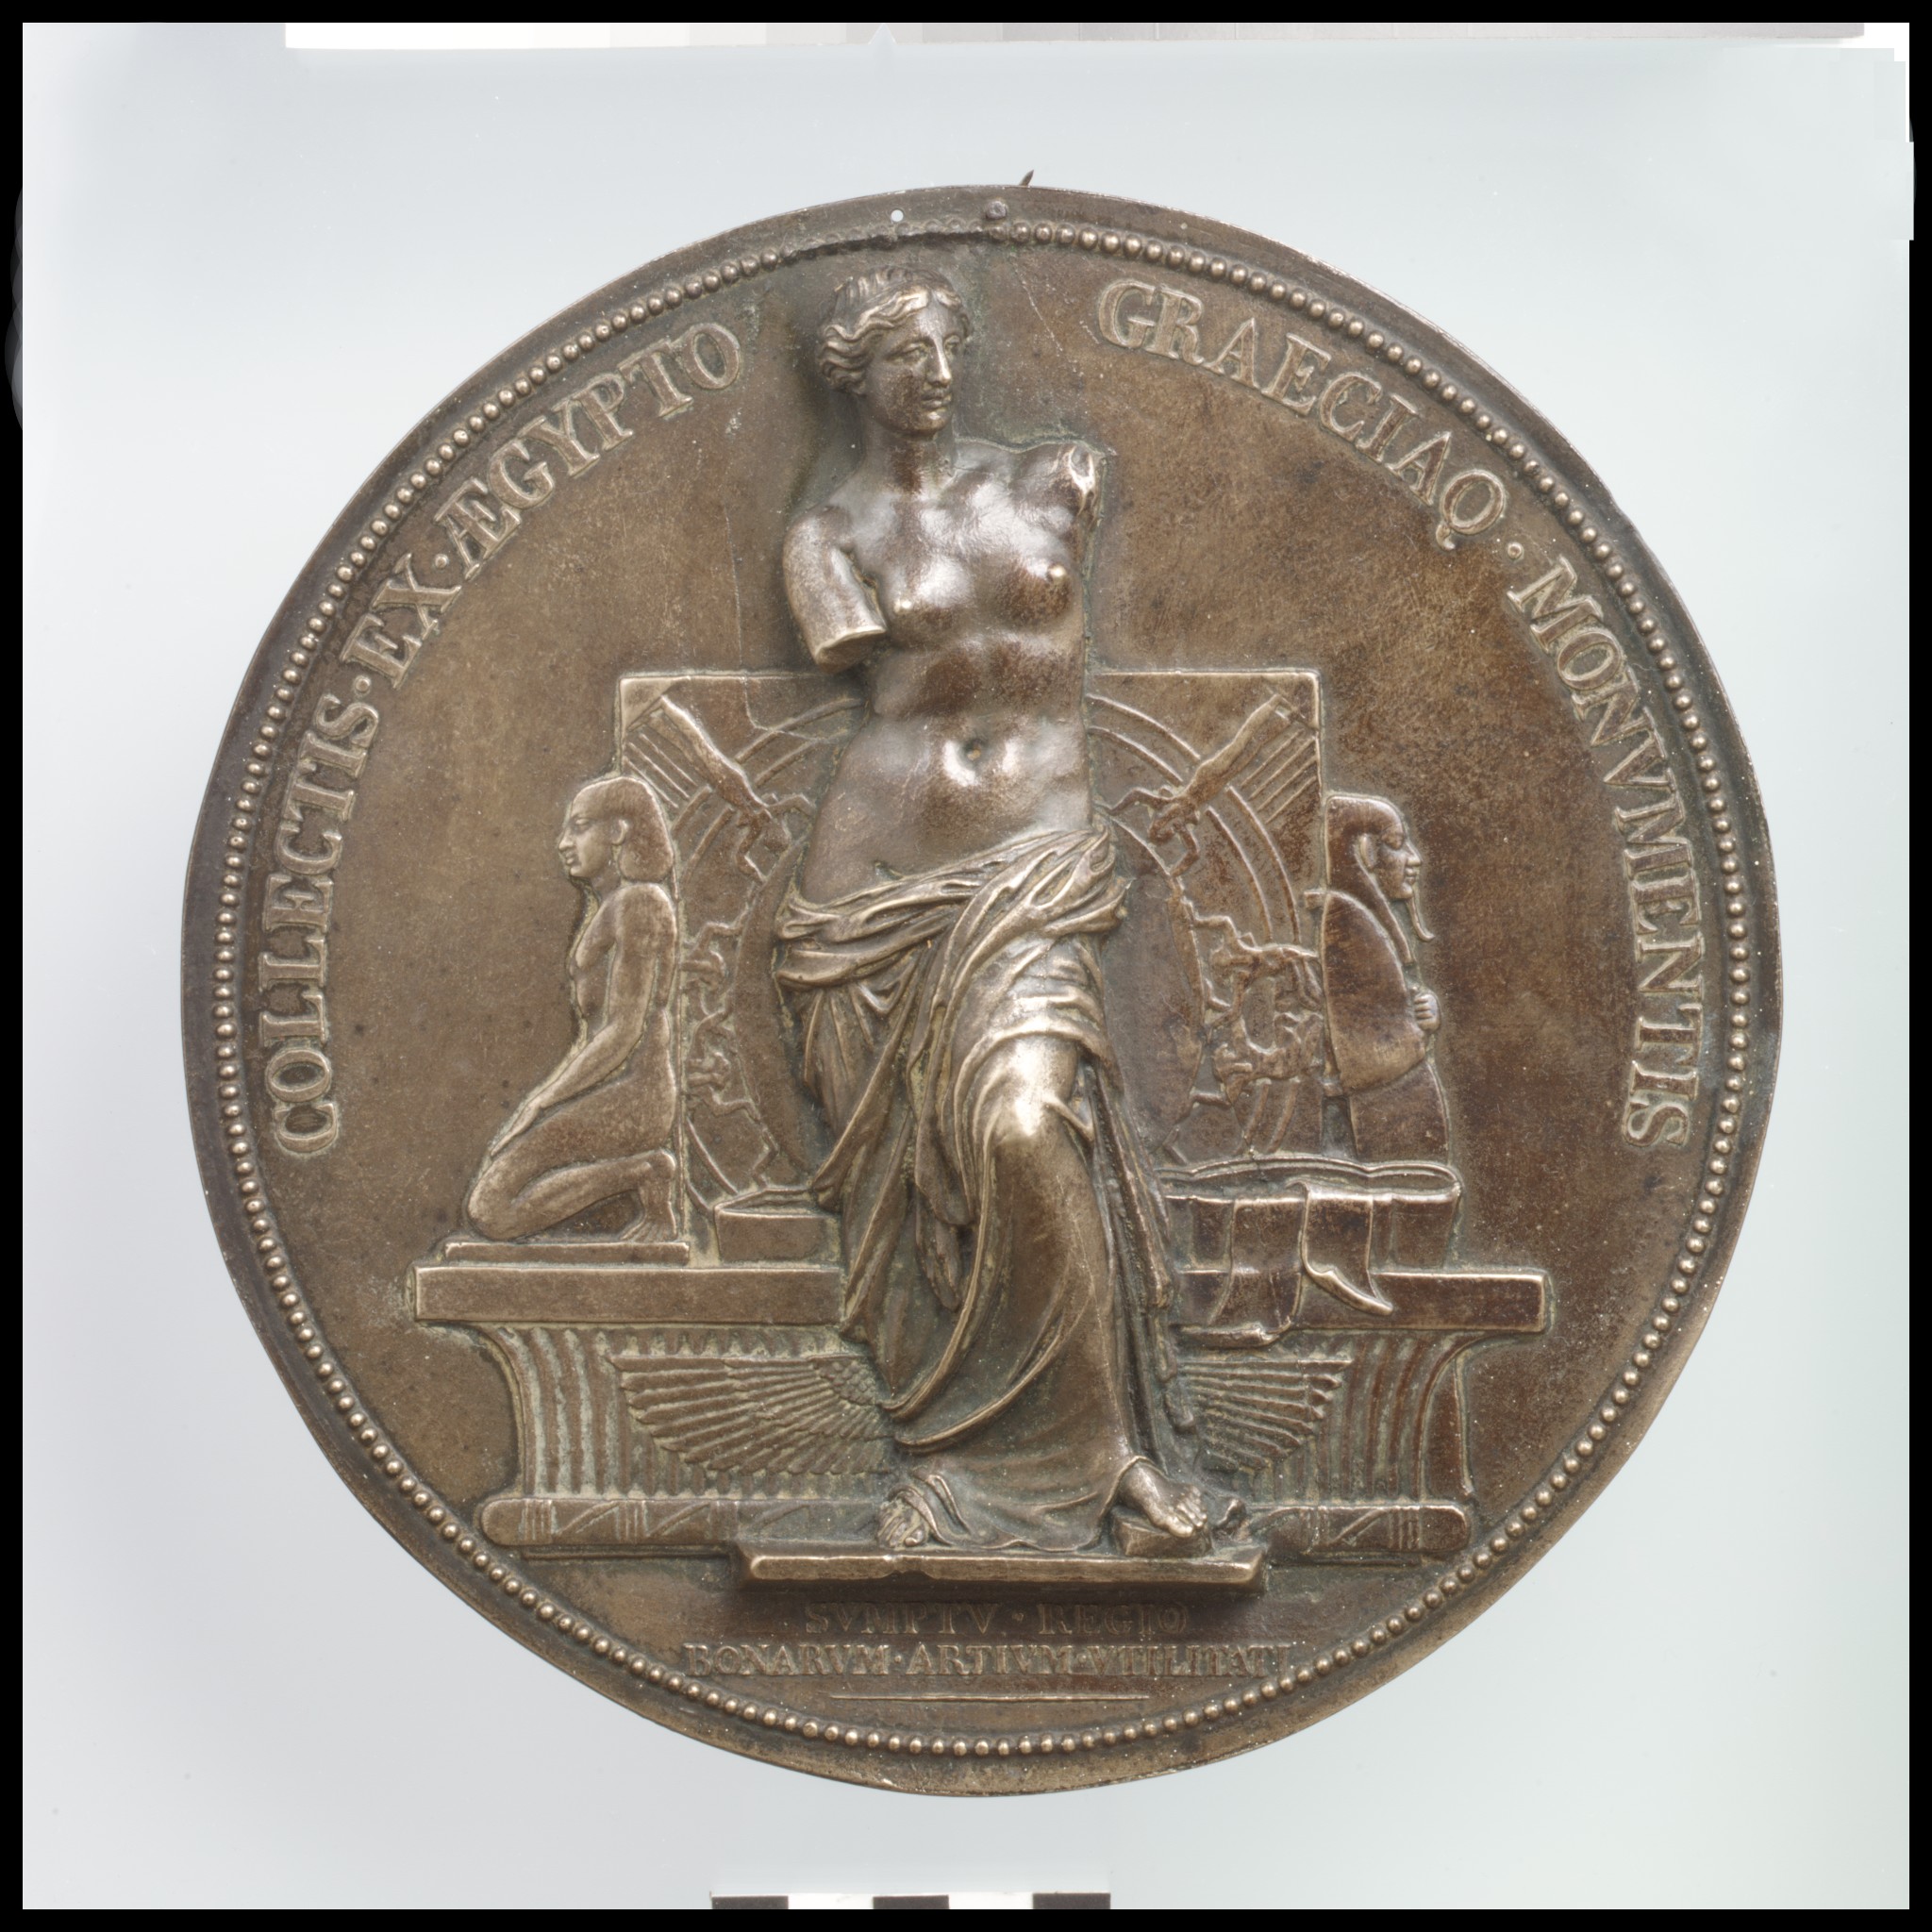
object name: medal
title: A uniface medal of the Ancient Greek and Egyptian Monuments of the Louvre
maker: alexis joseph depaulis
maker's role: artist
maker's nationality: french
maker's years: 1790-1867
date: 1701-1800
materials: bronze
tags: female nudes